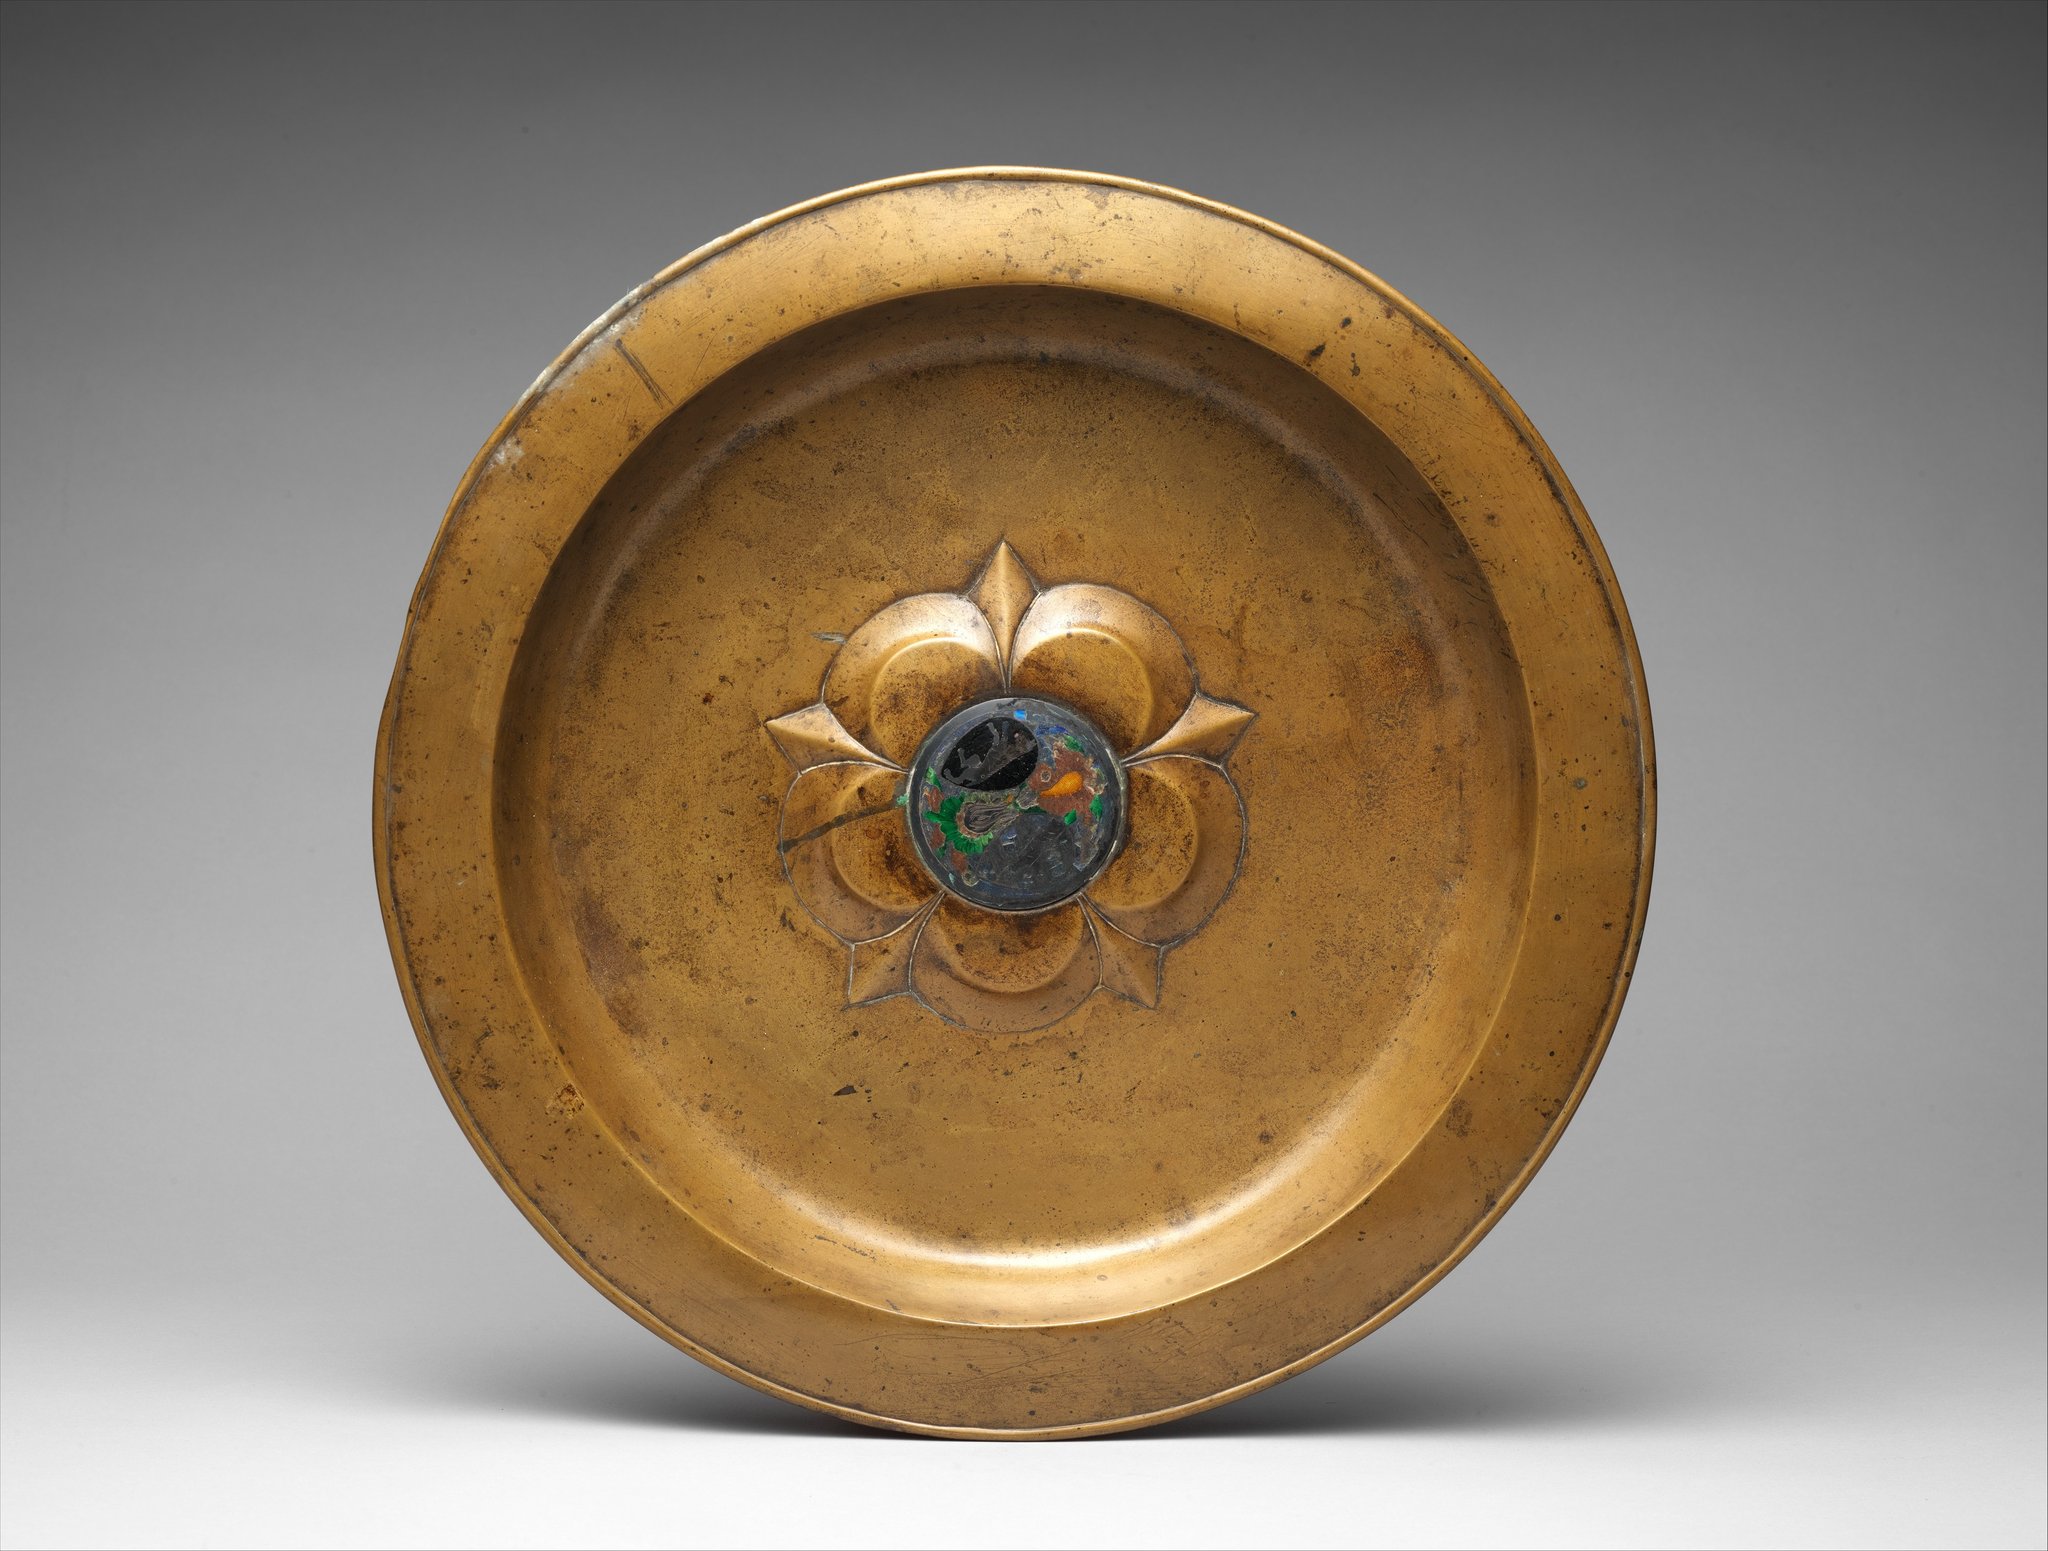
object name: plate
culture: south netherlandish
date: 1434-1466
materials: brass, enamel, silver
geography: netherlands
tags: dogs